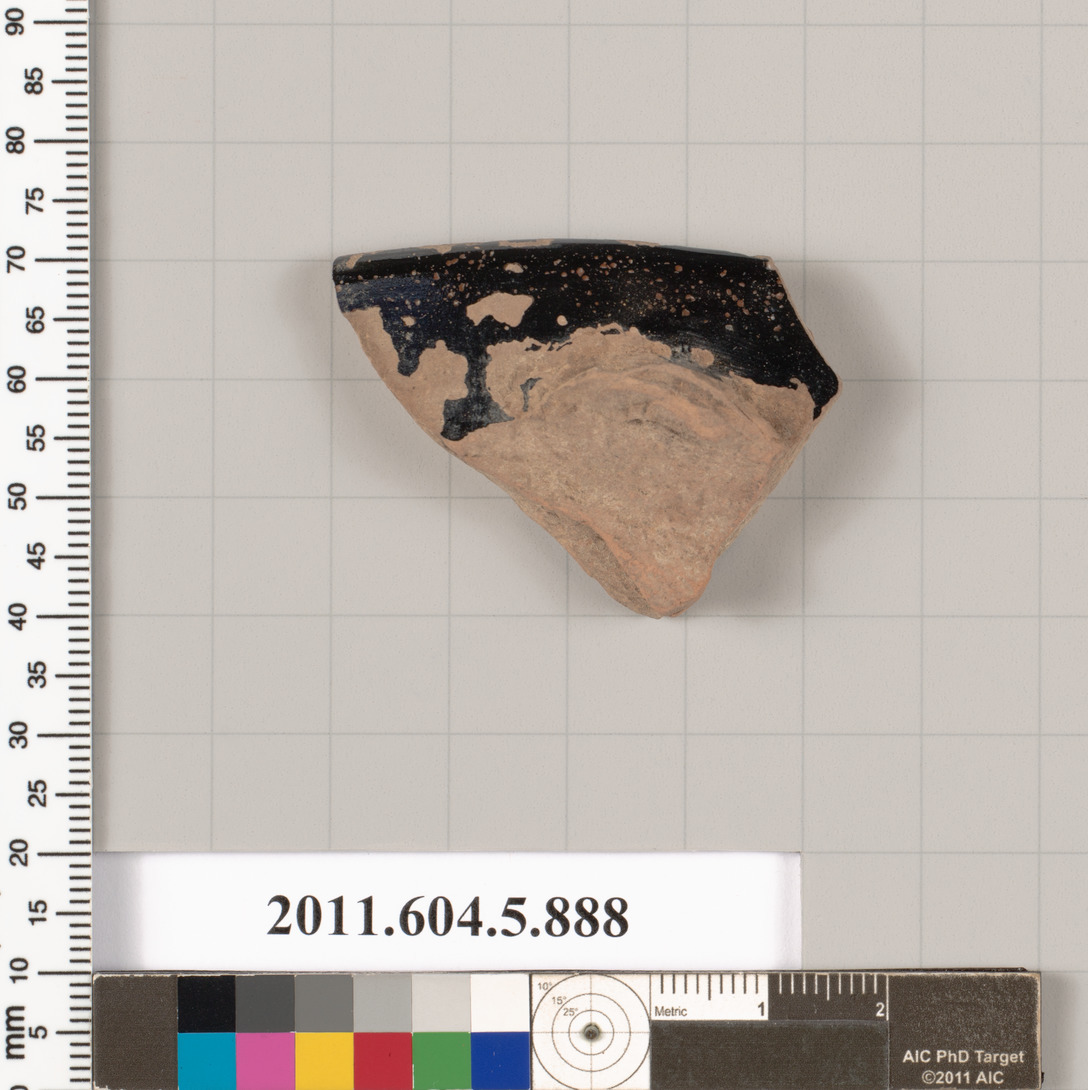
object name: kylix fragment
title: Terracotta rim fragment of a kylix (drinking cup)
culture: greek, attic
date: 600-401 BCE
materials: terracotta